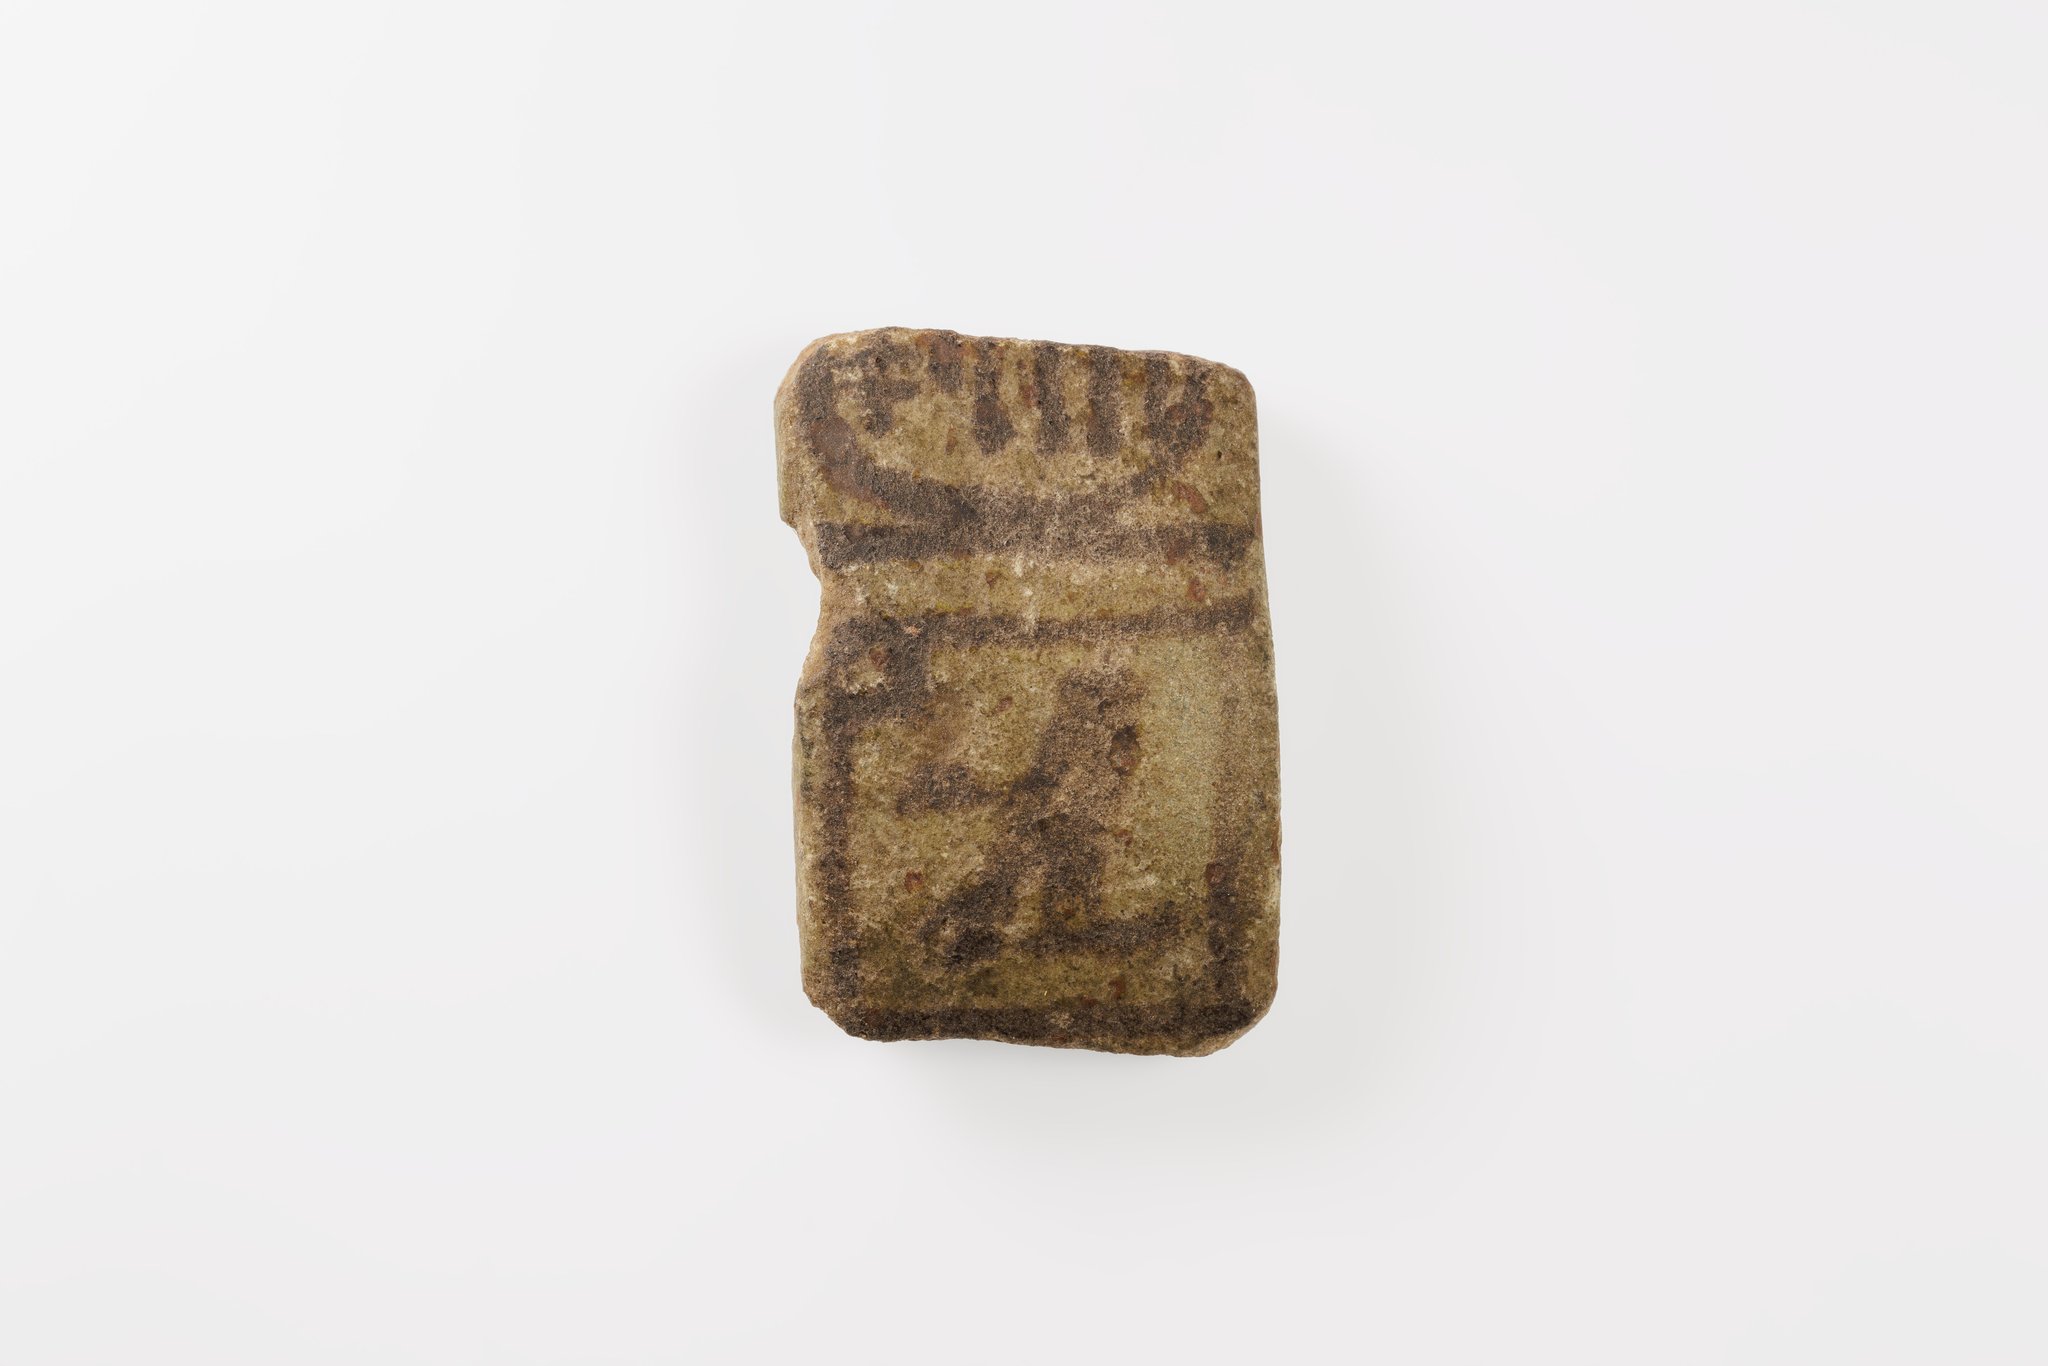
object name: votive bracelet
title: Fragment of a votive bracelet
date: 1295-1070 BCE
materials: faience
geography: egypt